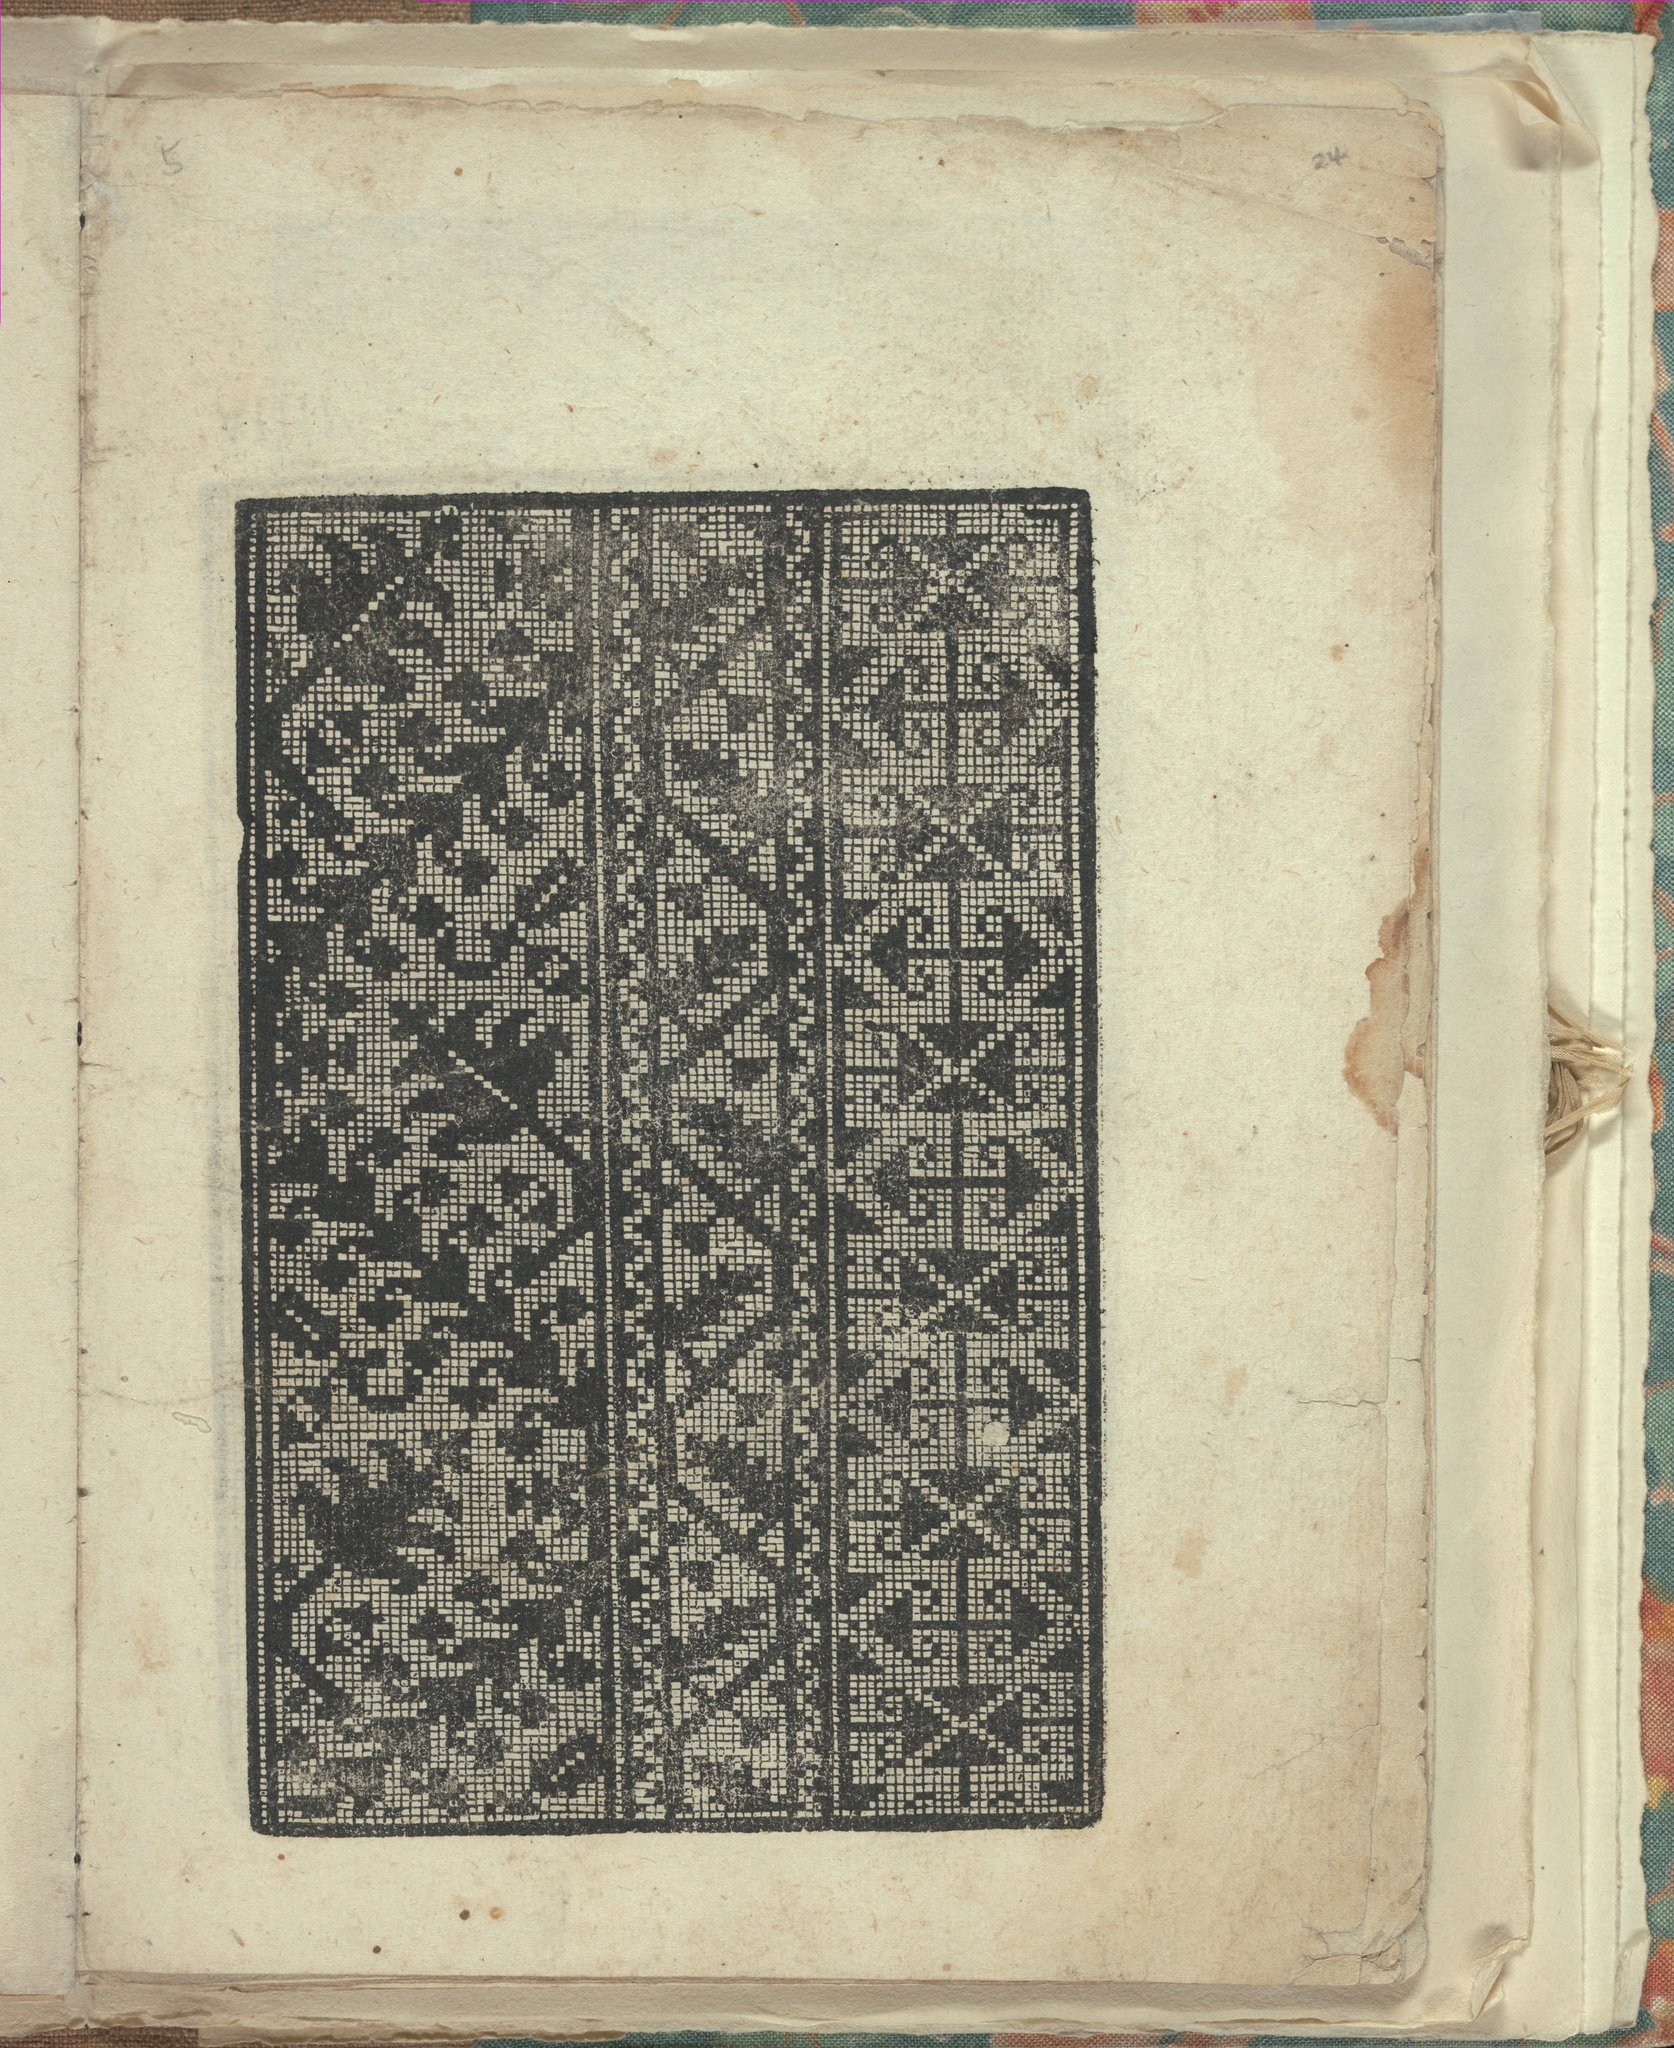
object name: book print ornament architecture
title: Opera Nova Universali intitulata Corona di racammi, page 24 (recto)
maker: giovanni andrea vavassore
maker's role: publisher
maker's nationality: italian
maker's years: 1530-1573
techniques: woodcut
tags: ornament